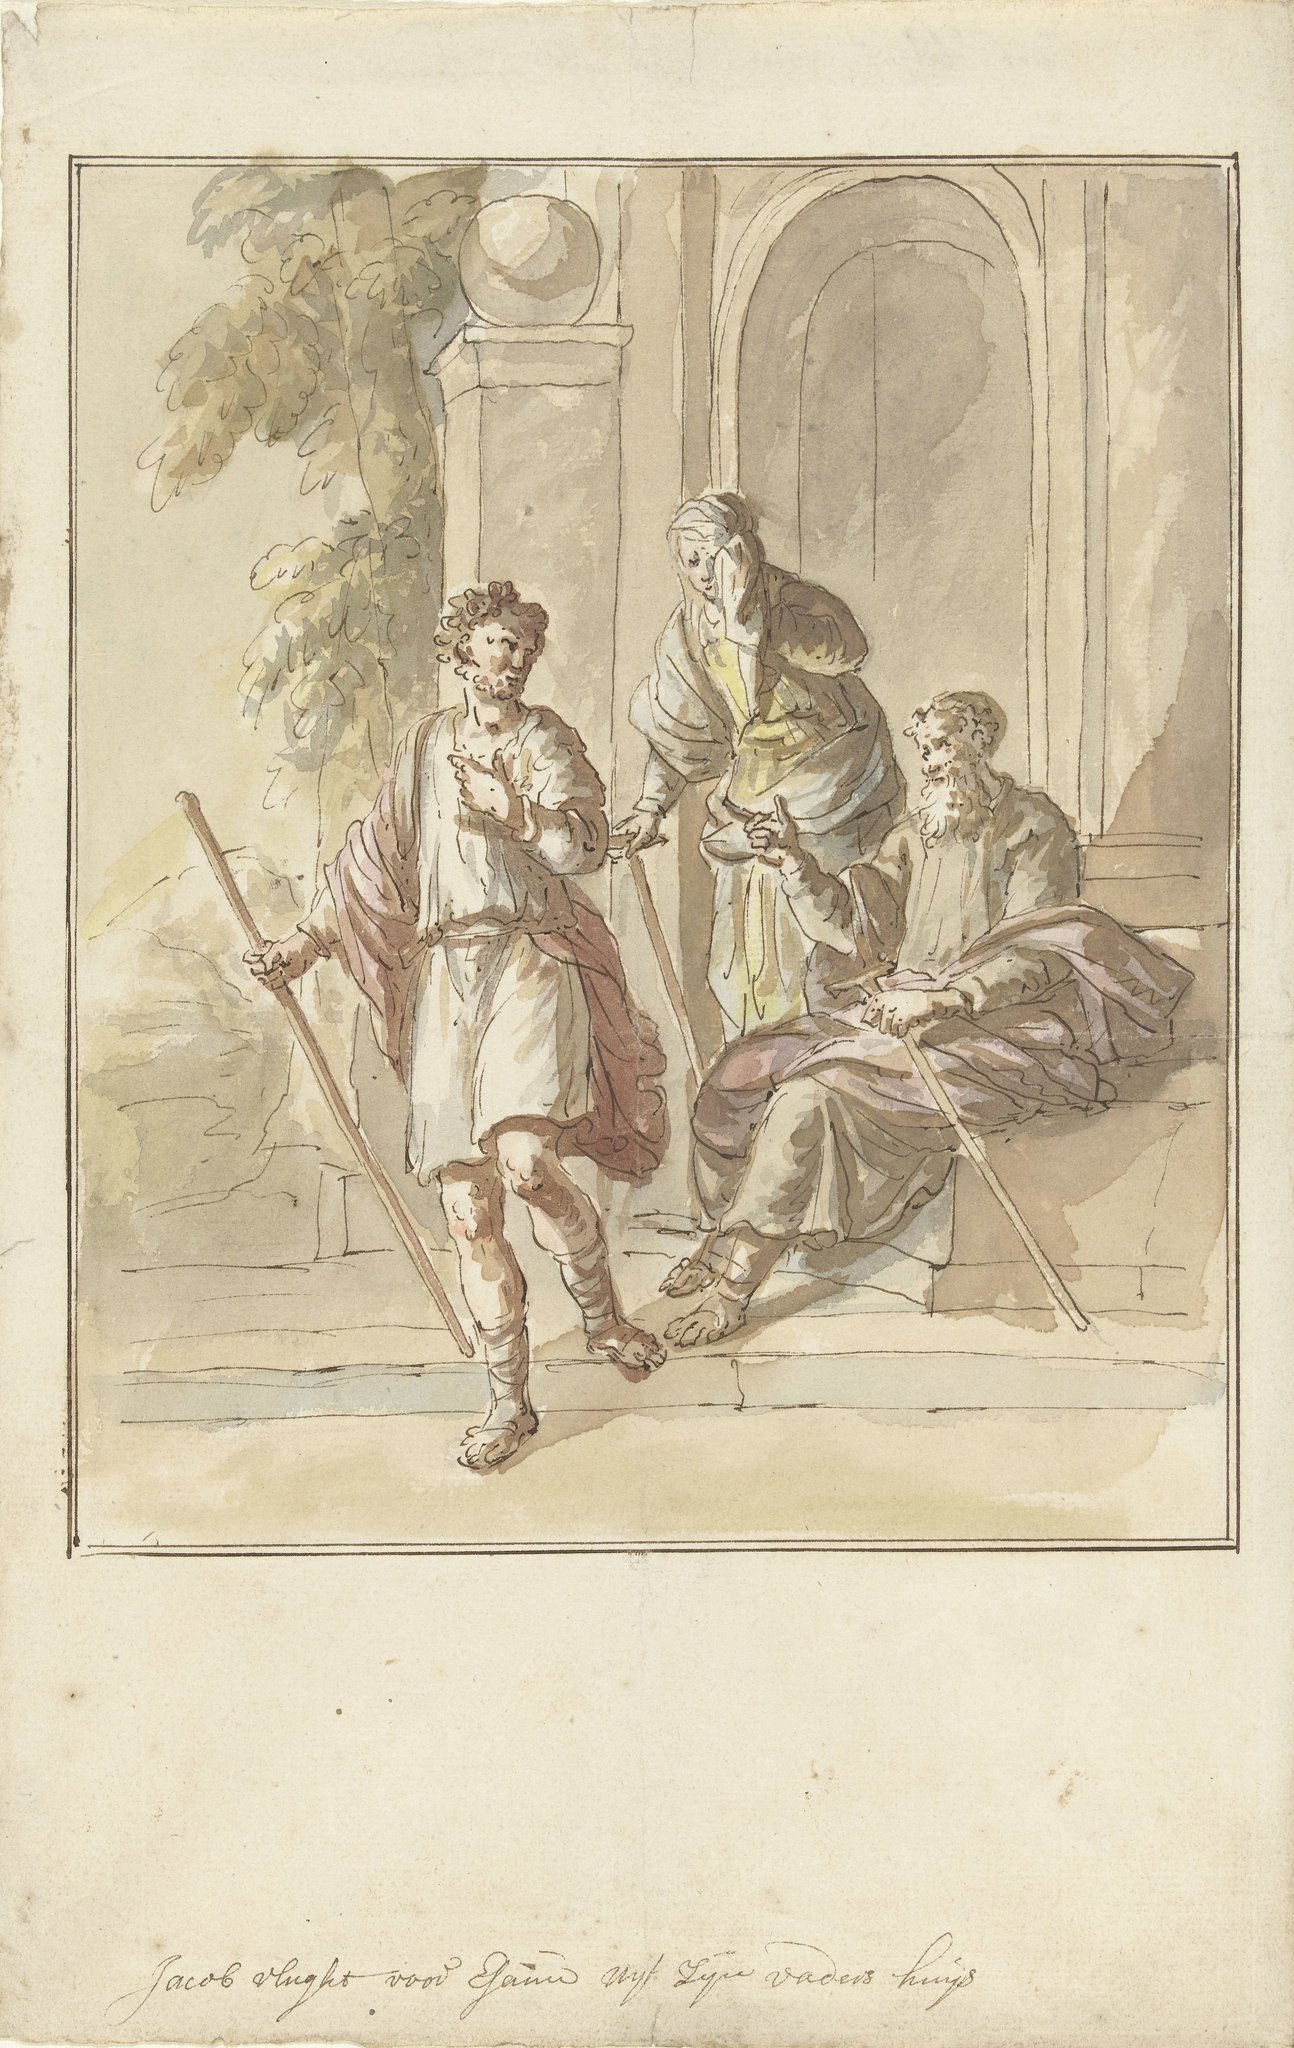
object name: watercolor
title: Jakob vlucht uit zijn ouderlijk huis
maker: elias van nijmegen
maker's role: draughtsman, painter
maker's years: 1667-1755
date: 1677-1755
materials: ink, paper, pencil, watercolor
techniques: brush, pen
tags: jacob leaves the house; esau marries again (genesis 28:1-10)